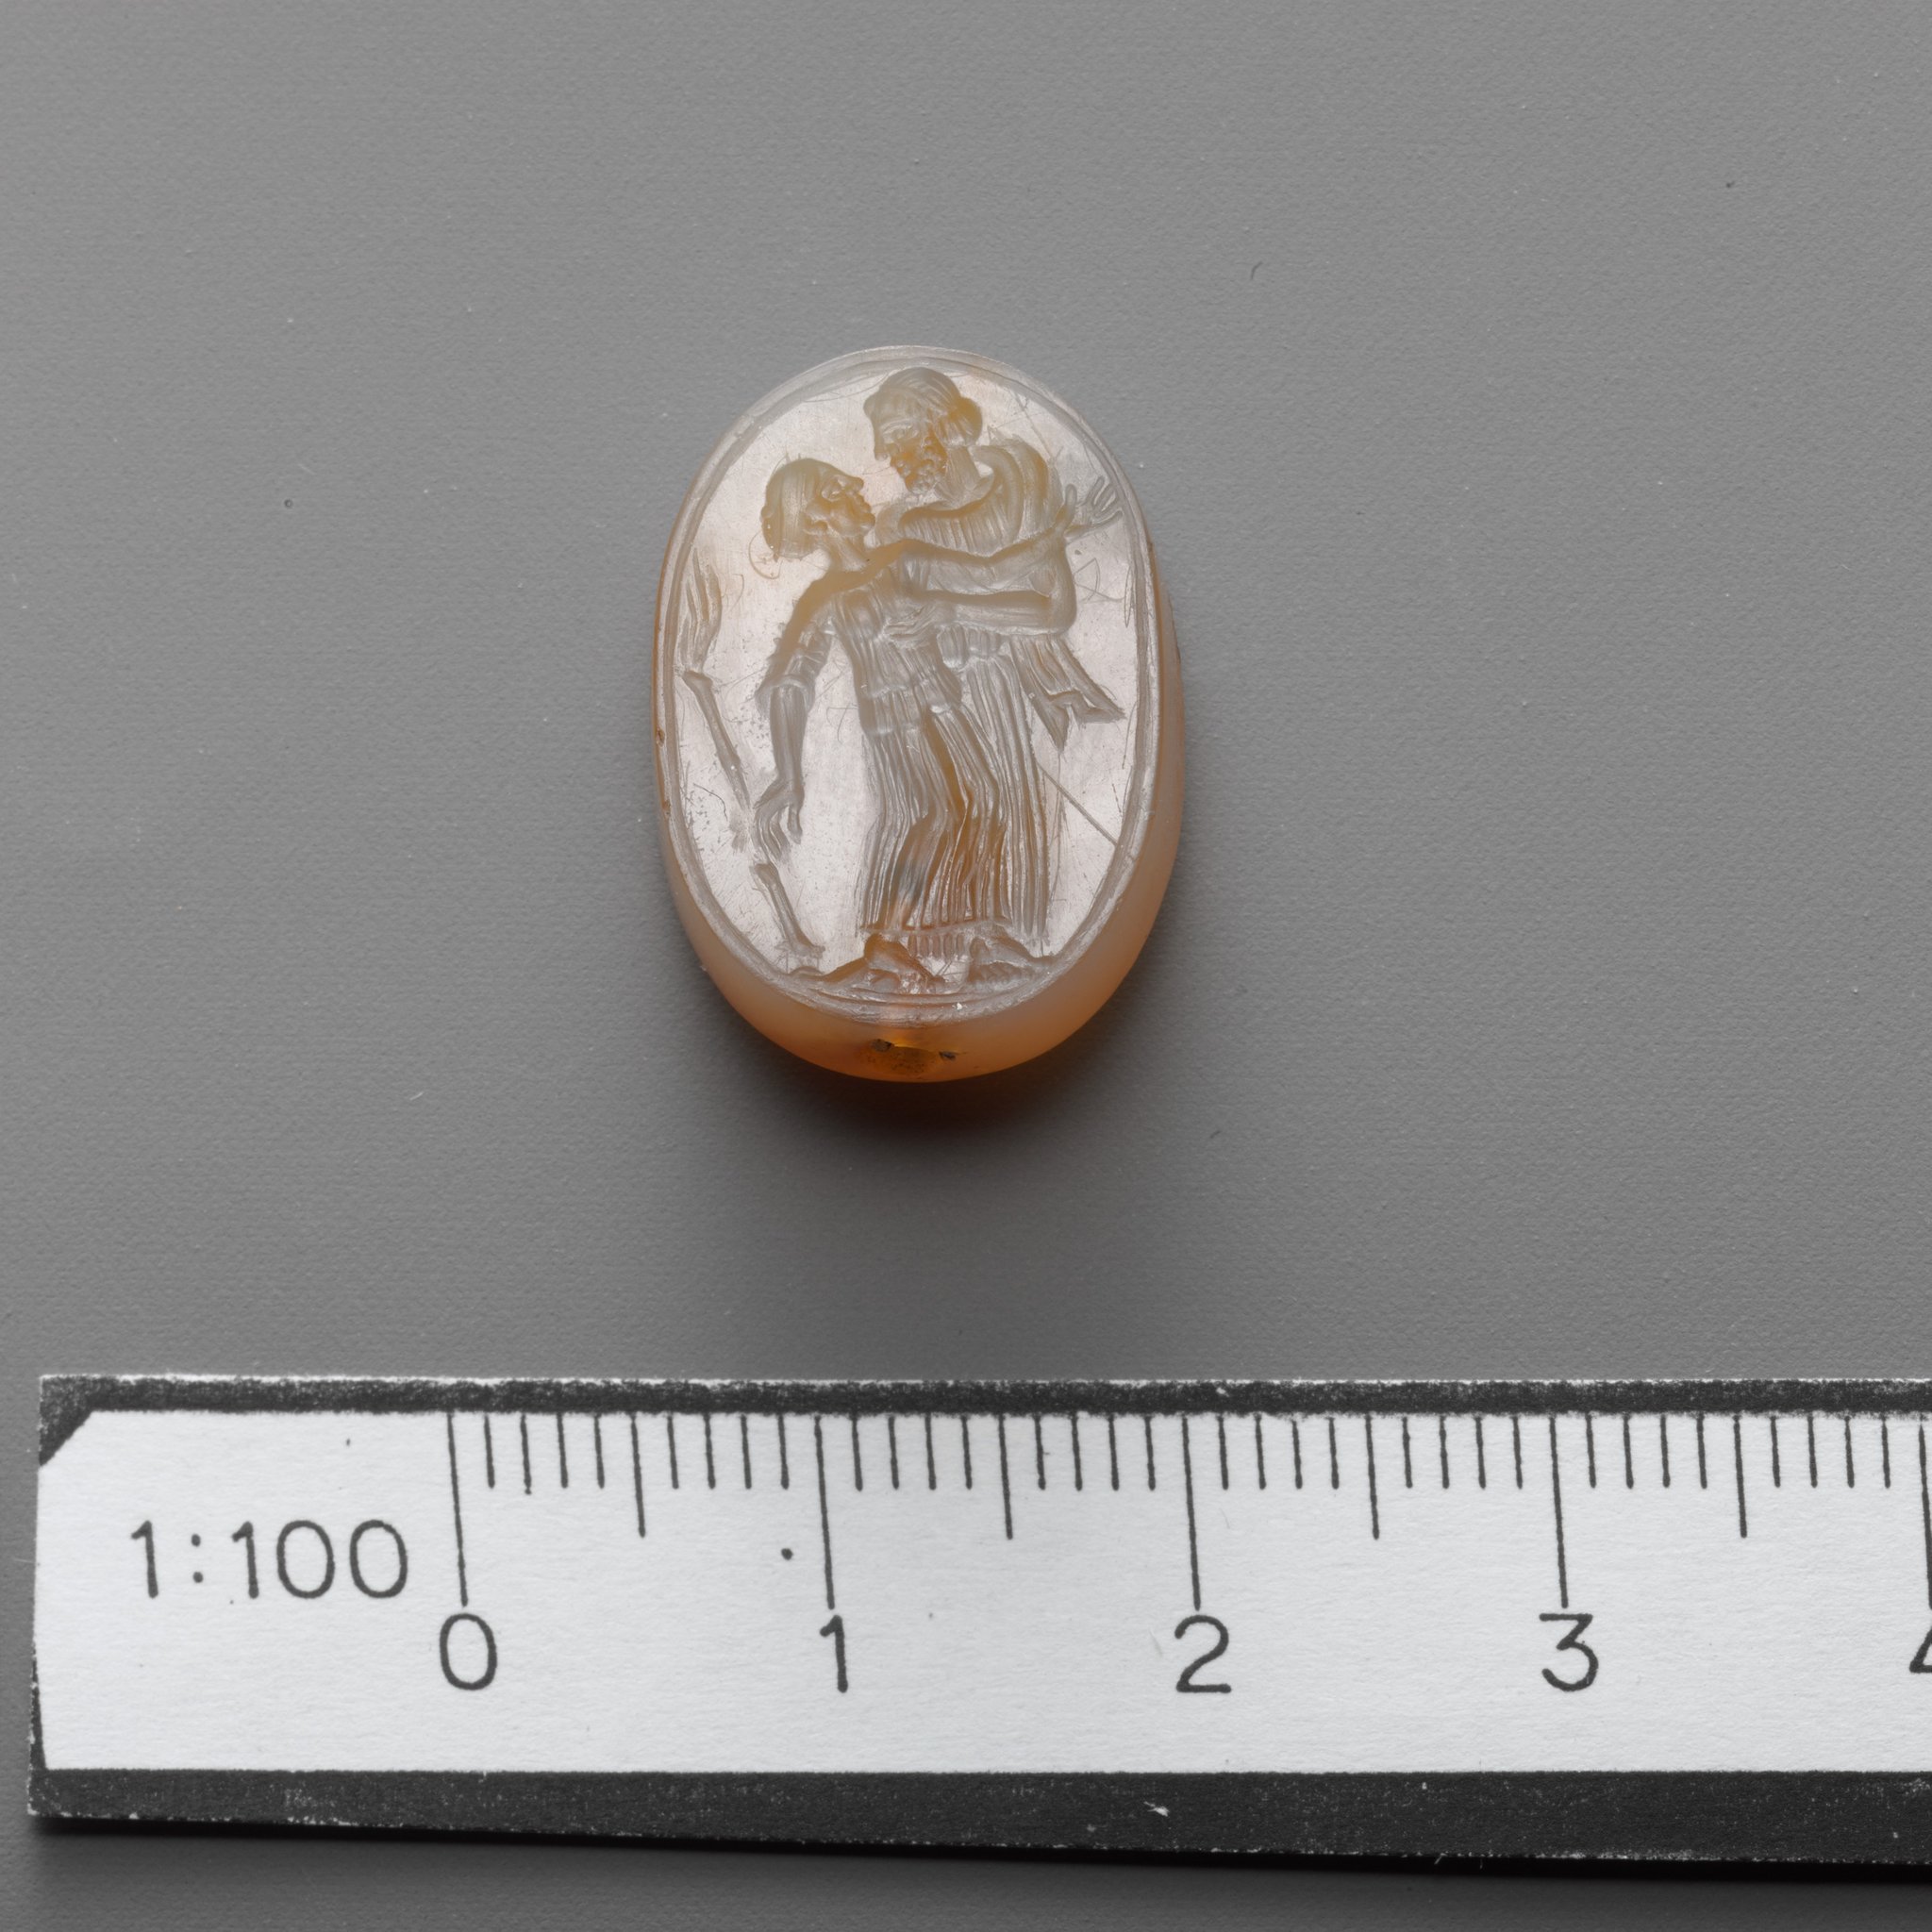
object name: ring with scaraboid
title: Chalcedony scaraboid in silver ring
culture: greek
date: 467-435 BCE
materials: stone, silver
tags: persephone,hades